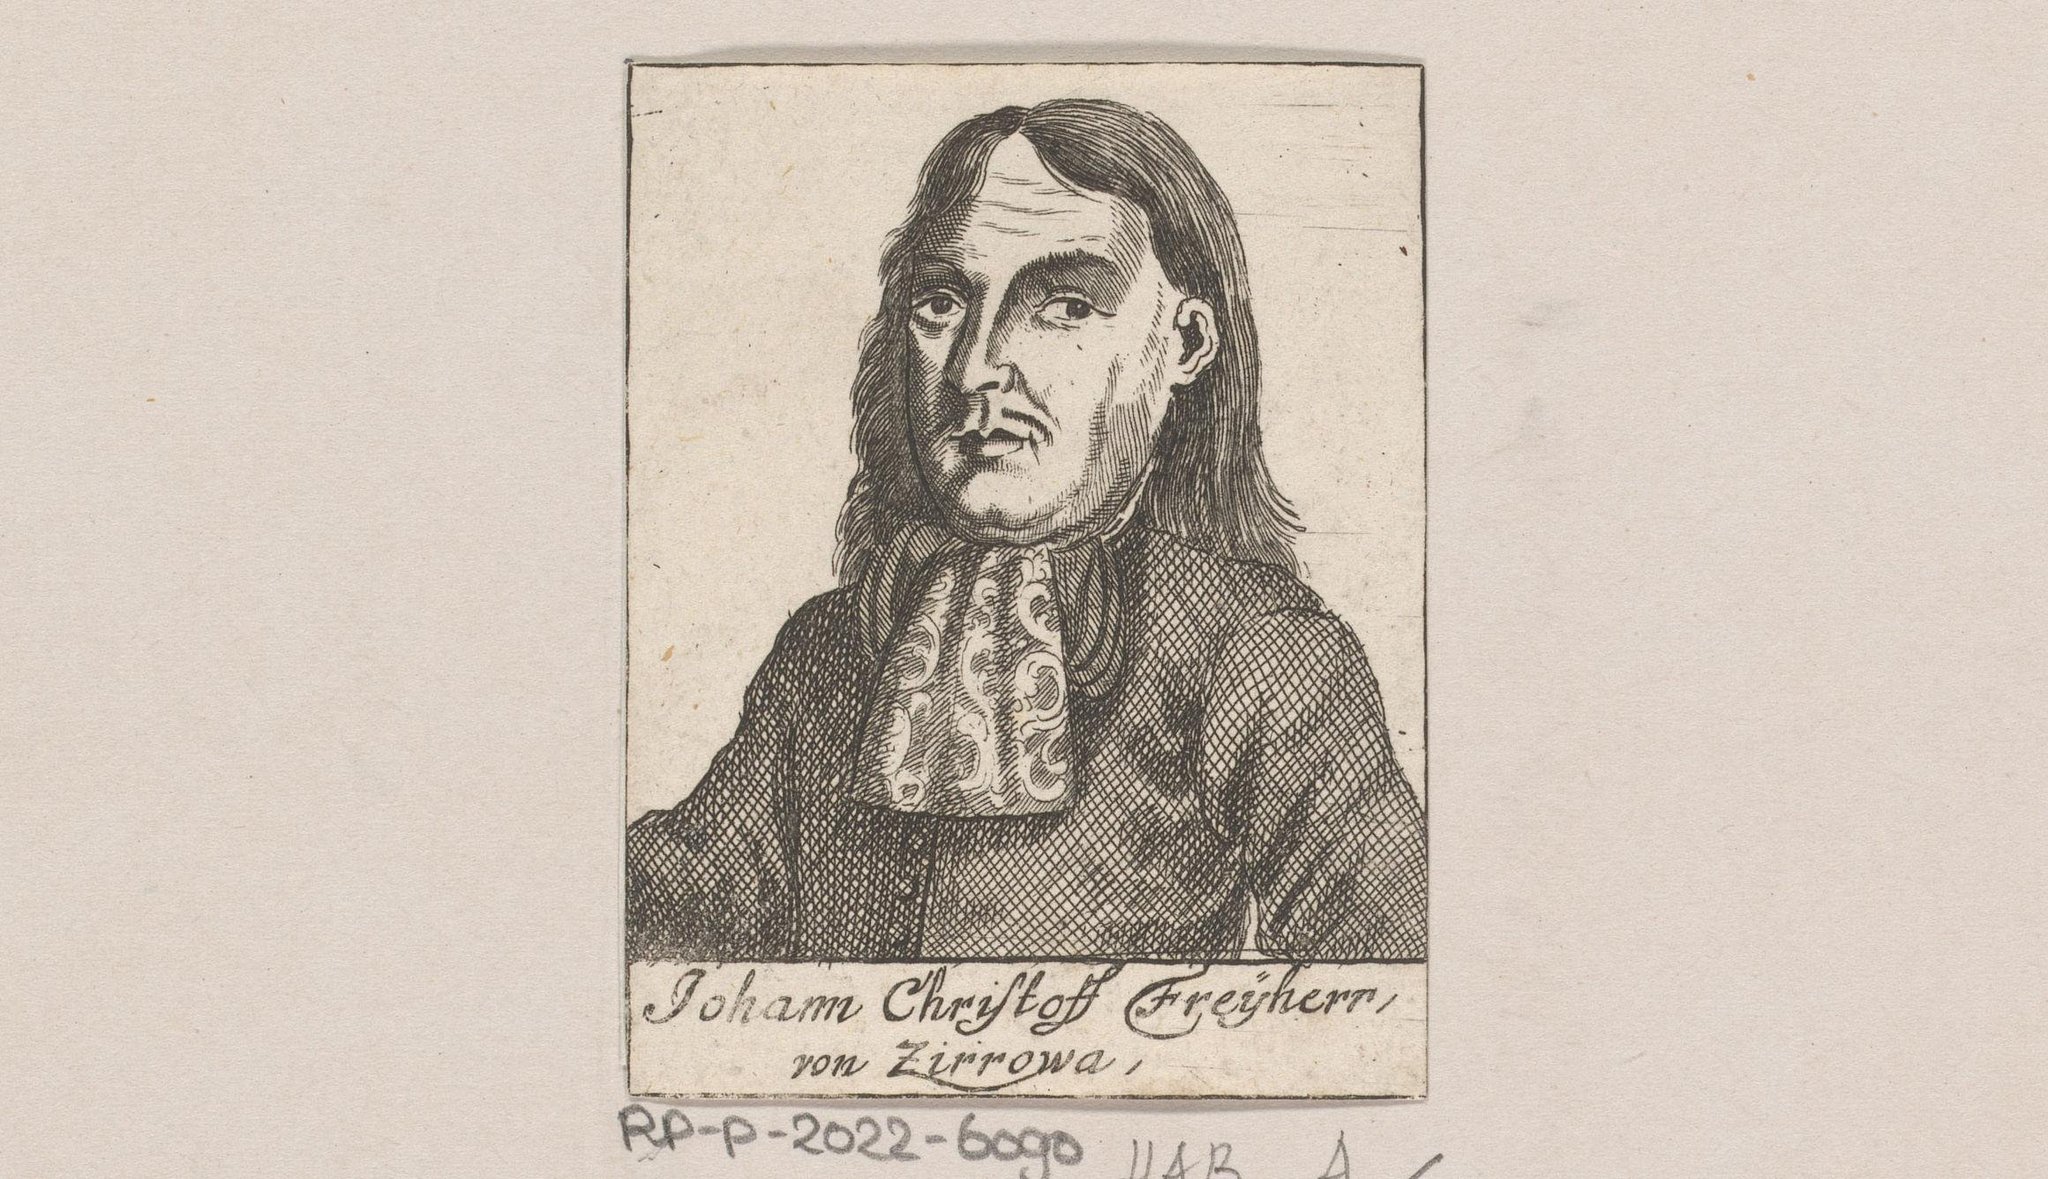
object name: print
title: Portret van Johann Christoff von Zirrowa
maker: Anonymous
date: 1650-1799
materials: paper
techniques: engraving, etching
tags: historical persons